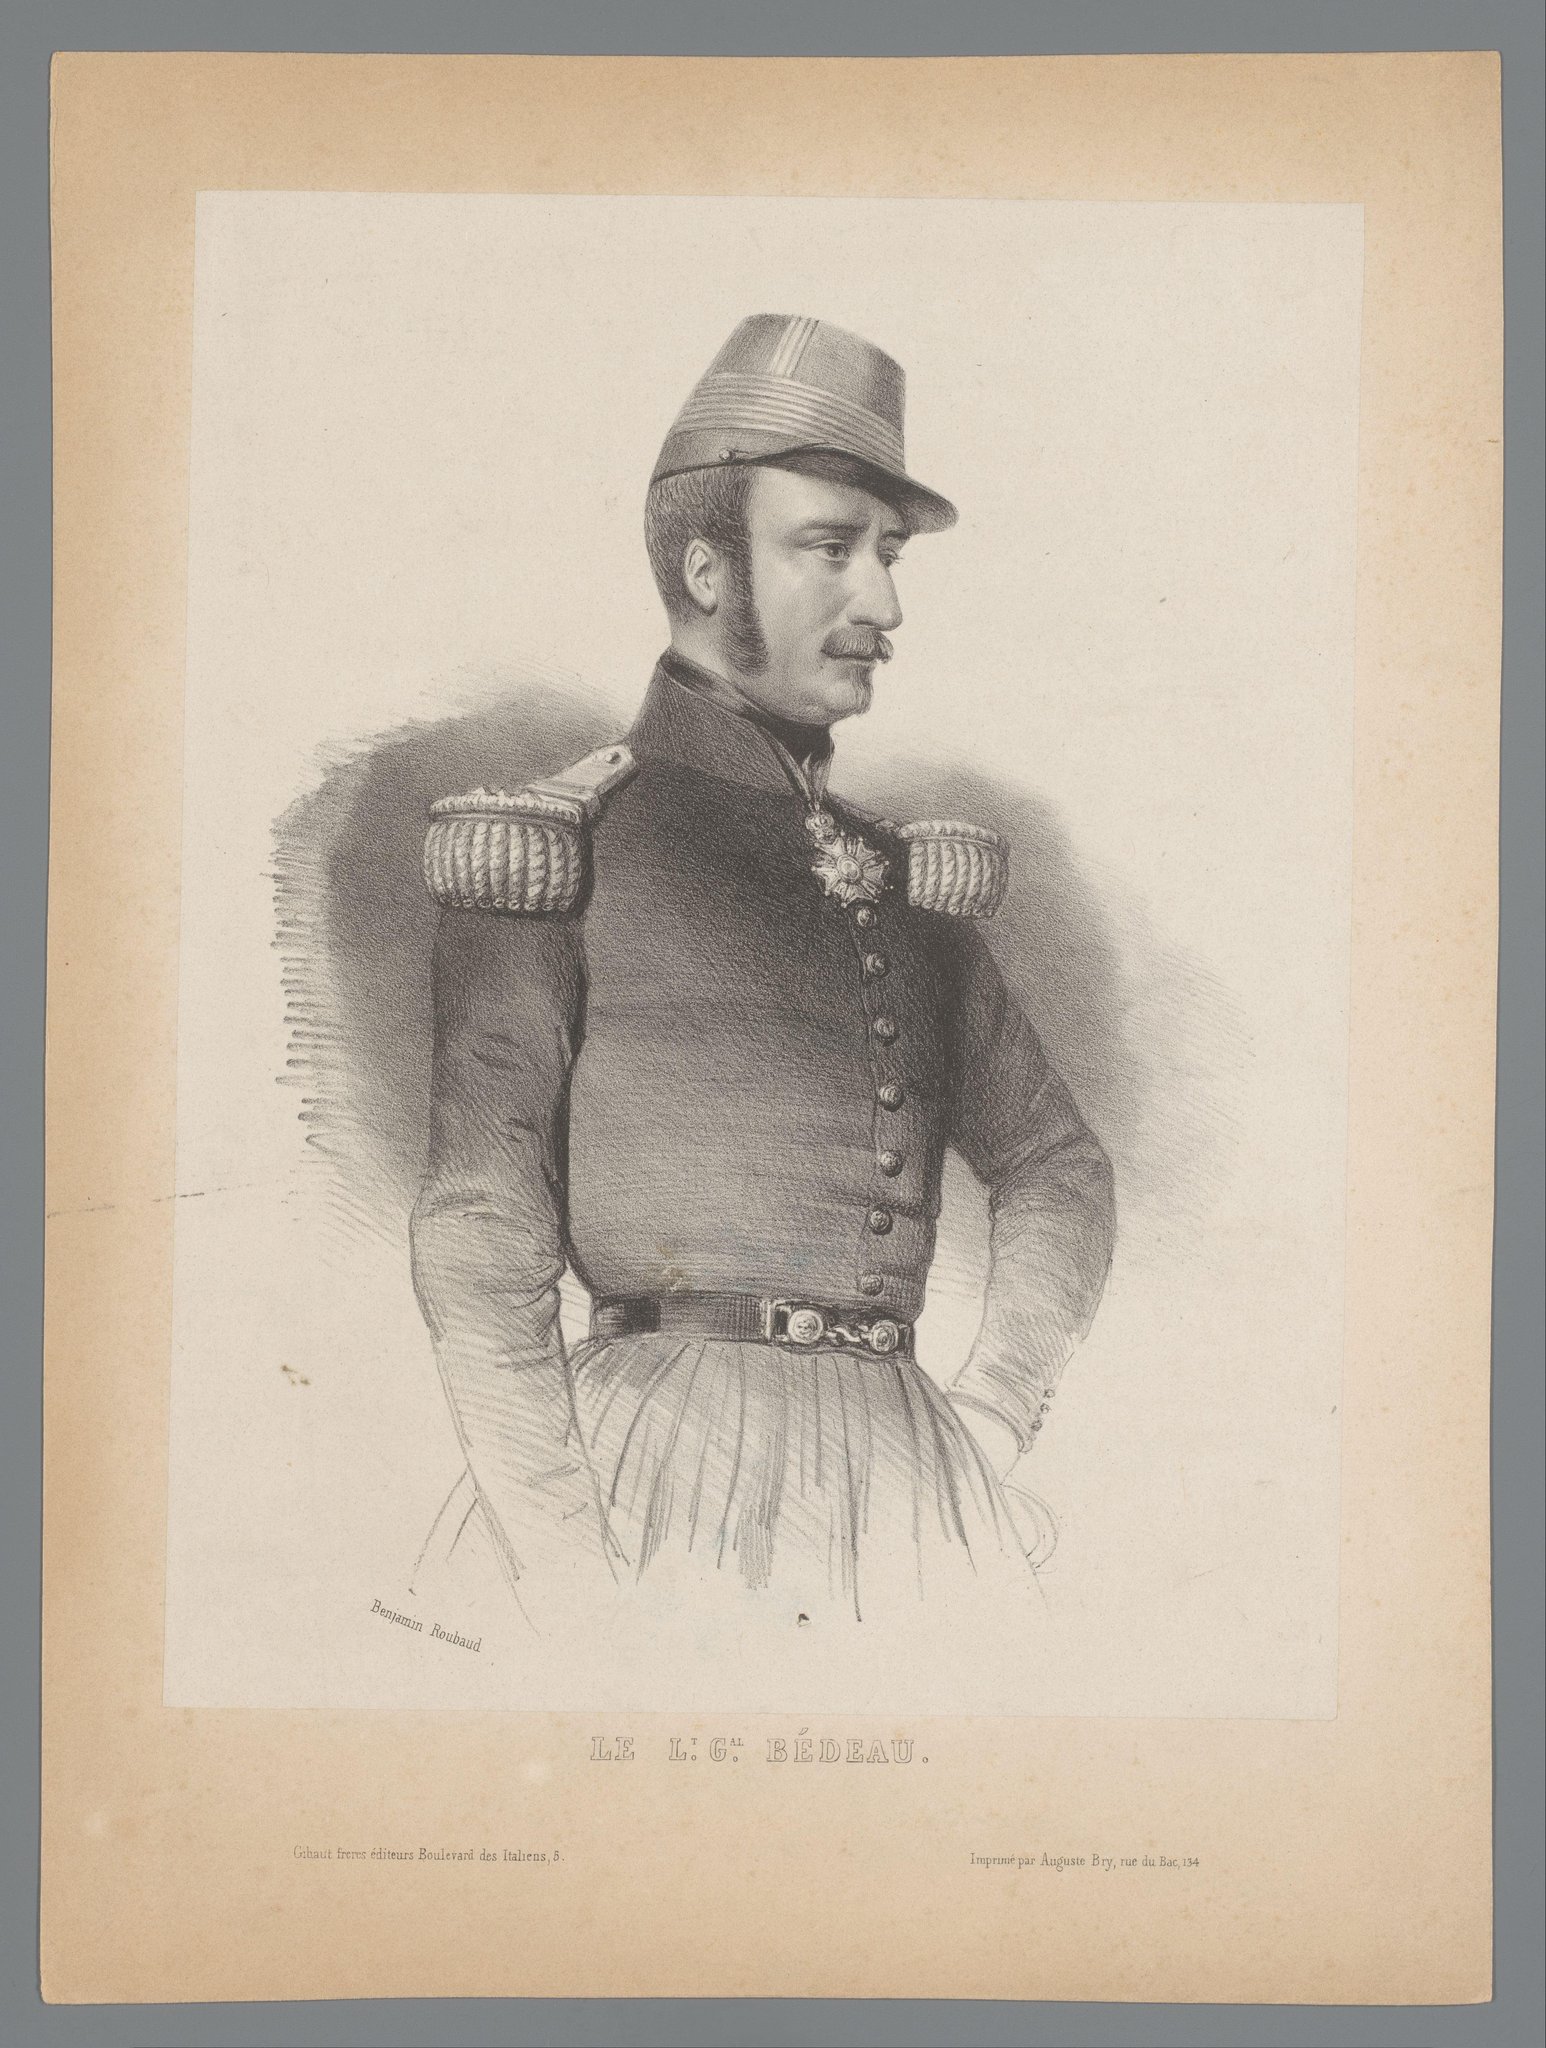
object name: print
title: Le lt. gal. Bédeau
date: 1842-1844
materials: paper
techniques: lithograph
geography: paris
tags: politician, commander-in-chief, general, marshal, historical persons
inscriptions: collector's mark: Lugt 2228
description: Prent waarschijnlijk deel van Benjamins Roubauds prentserie: Souvenirs d'Afrique. Parijs: Gihaut frères, 1842-1846. In de eerste uitgeefronde (1842-1844) bracht hij individuele portretten uit. De prentmaker kwam in 1846 nog met aanvullende prenten voor deze serie onder de noemer 'inheemsen' (indigènes) met samengestelde afbeeeldingen en groepstaferelen (zie: https://www.splrarebooks.com/collection/view/album-dafrique/).